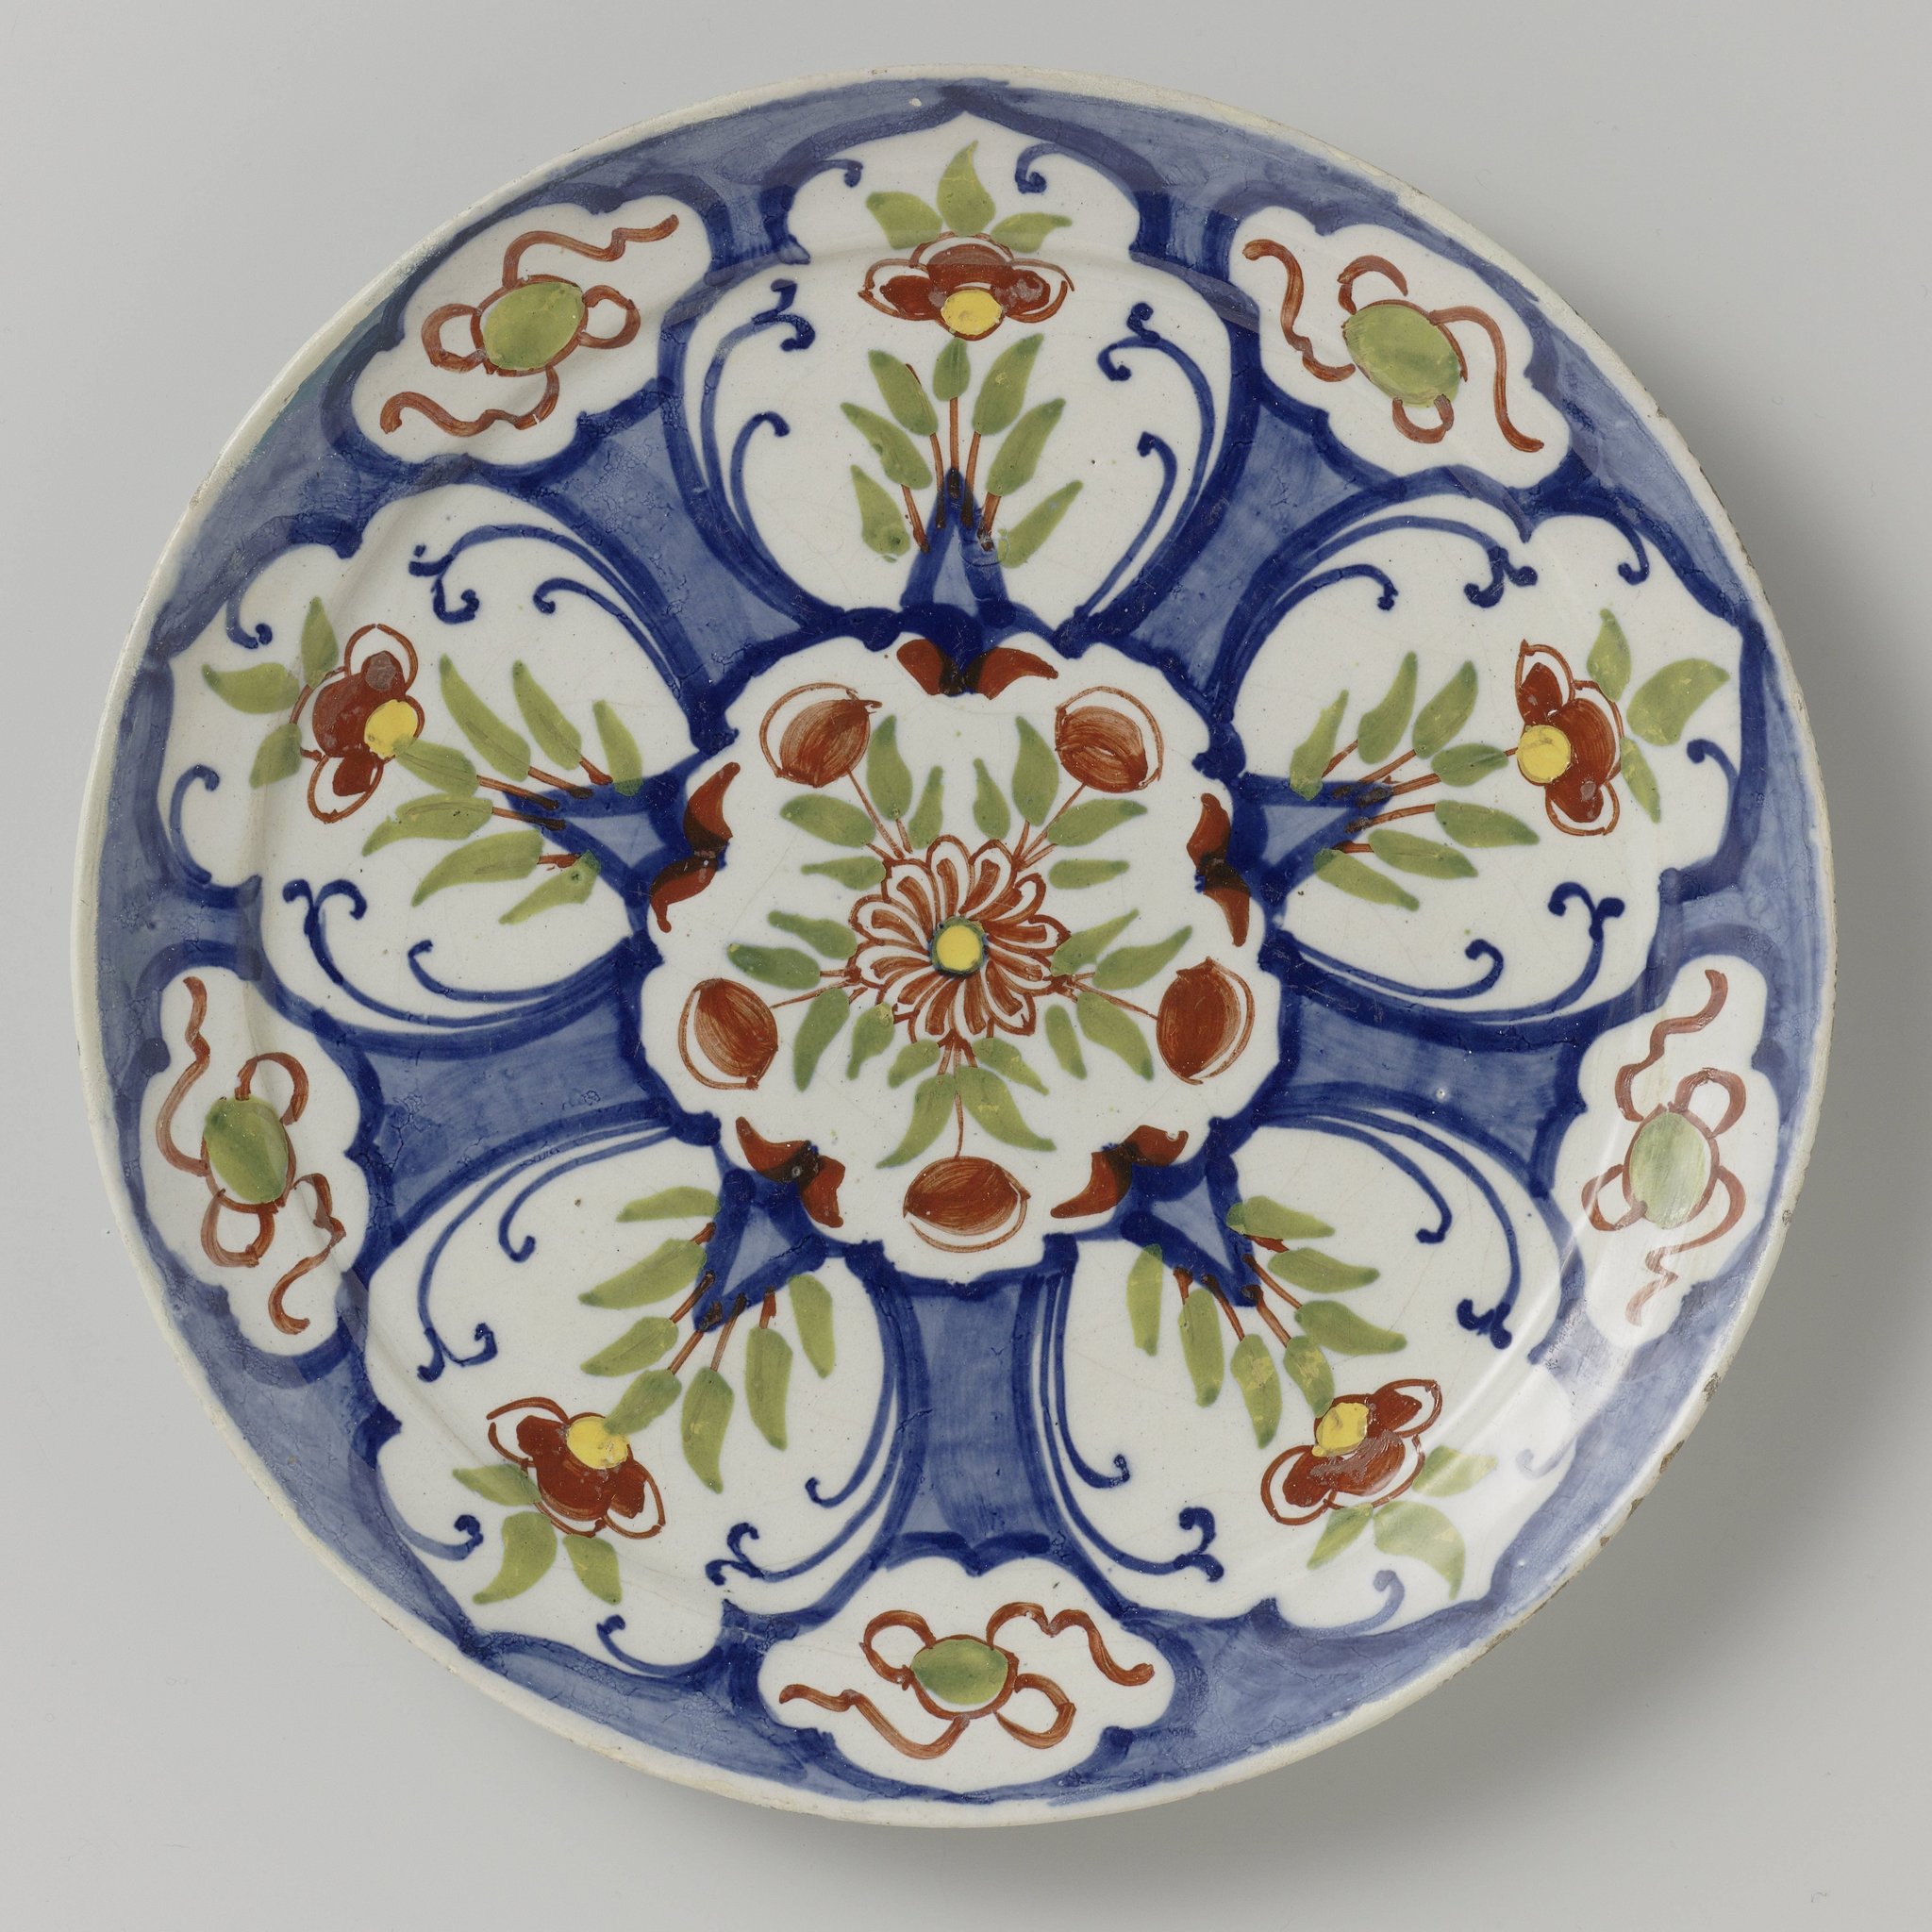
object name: plate dish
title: bord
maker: Anonymous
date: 1730-1770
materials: earthenware, glaze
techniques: painted, polychromy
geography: delft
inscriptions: collector's mark, ge: ‘koninklijk oudheidkundig genootschap no. 46’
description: Rond bord van veelkleurig beschilderde faience, met in het midden een medaillon met daarin een bloem en bladeren in de kleuren groen en rood. Daar omheen zijn op een blauwe achtergrond vijf witte vakken waarbinnen bloem- en bladversieringen. Bij het bord horen twee identieke borden met de invnrs. BK-KOG-2432-a en BK-KOG-2432-c.